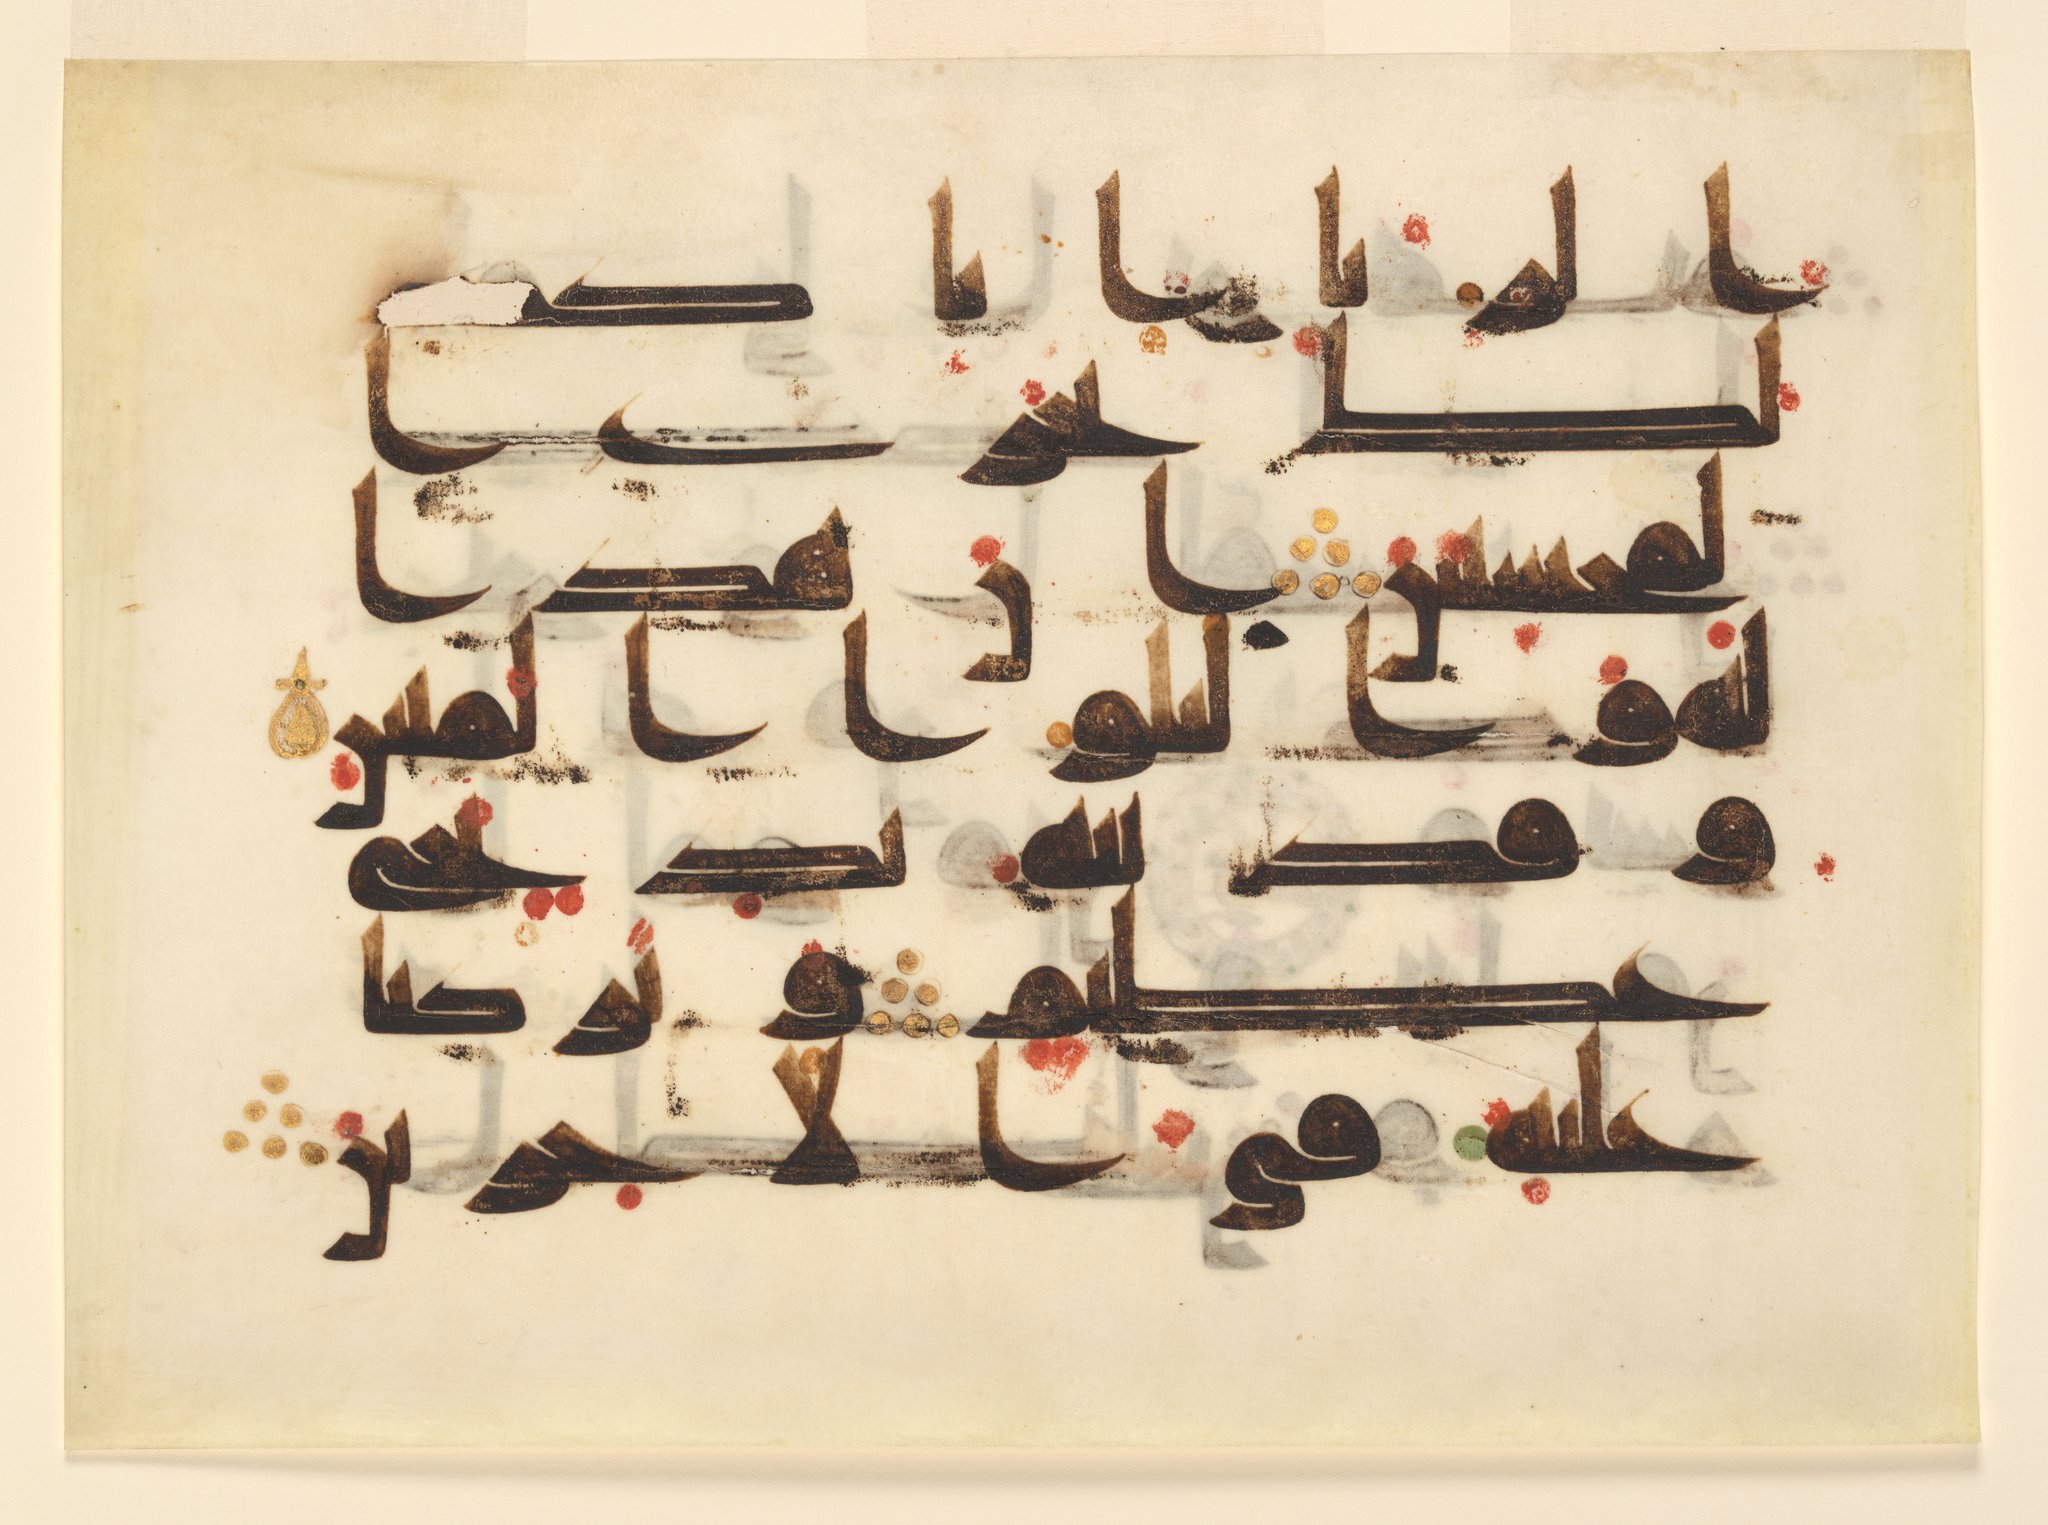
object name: folio from a non illustrated manuscript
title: Folio from a Qur'an Manuscript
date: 867-933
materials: gold, ink, parchment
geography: syria